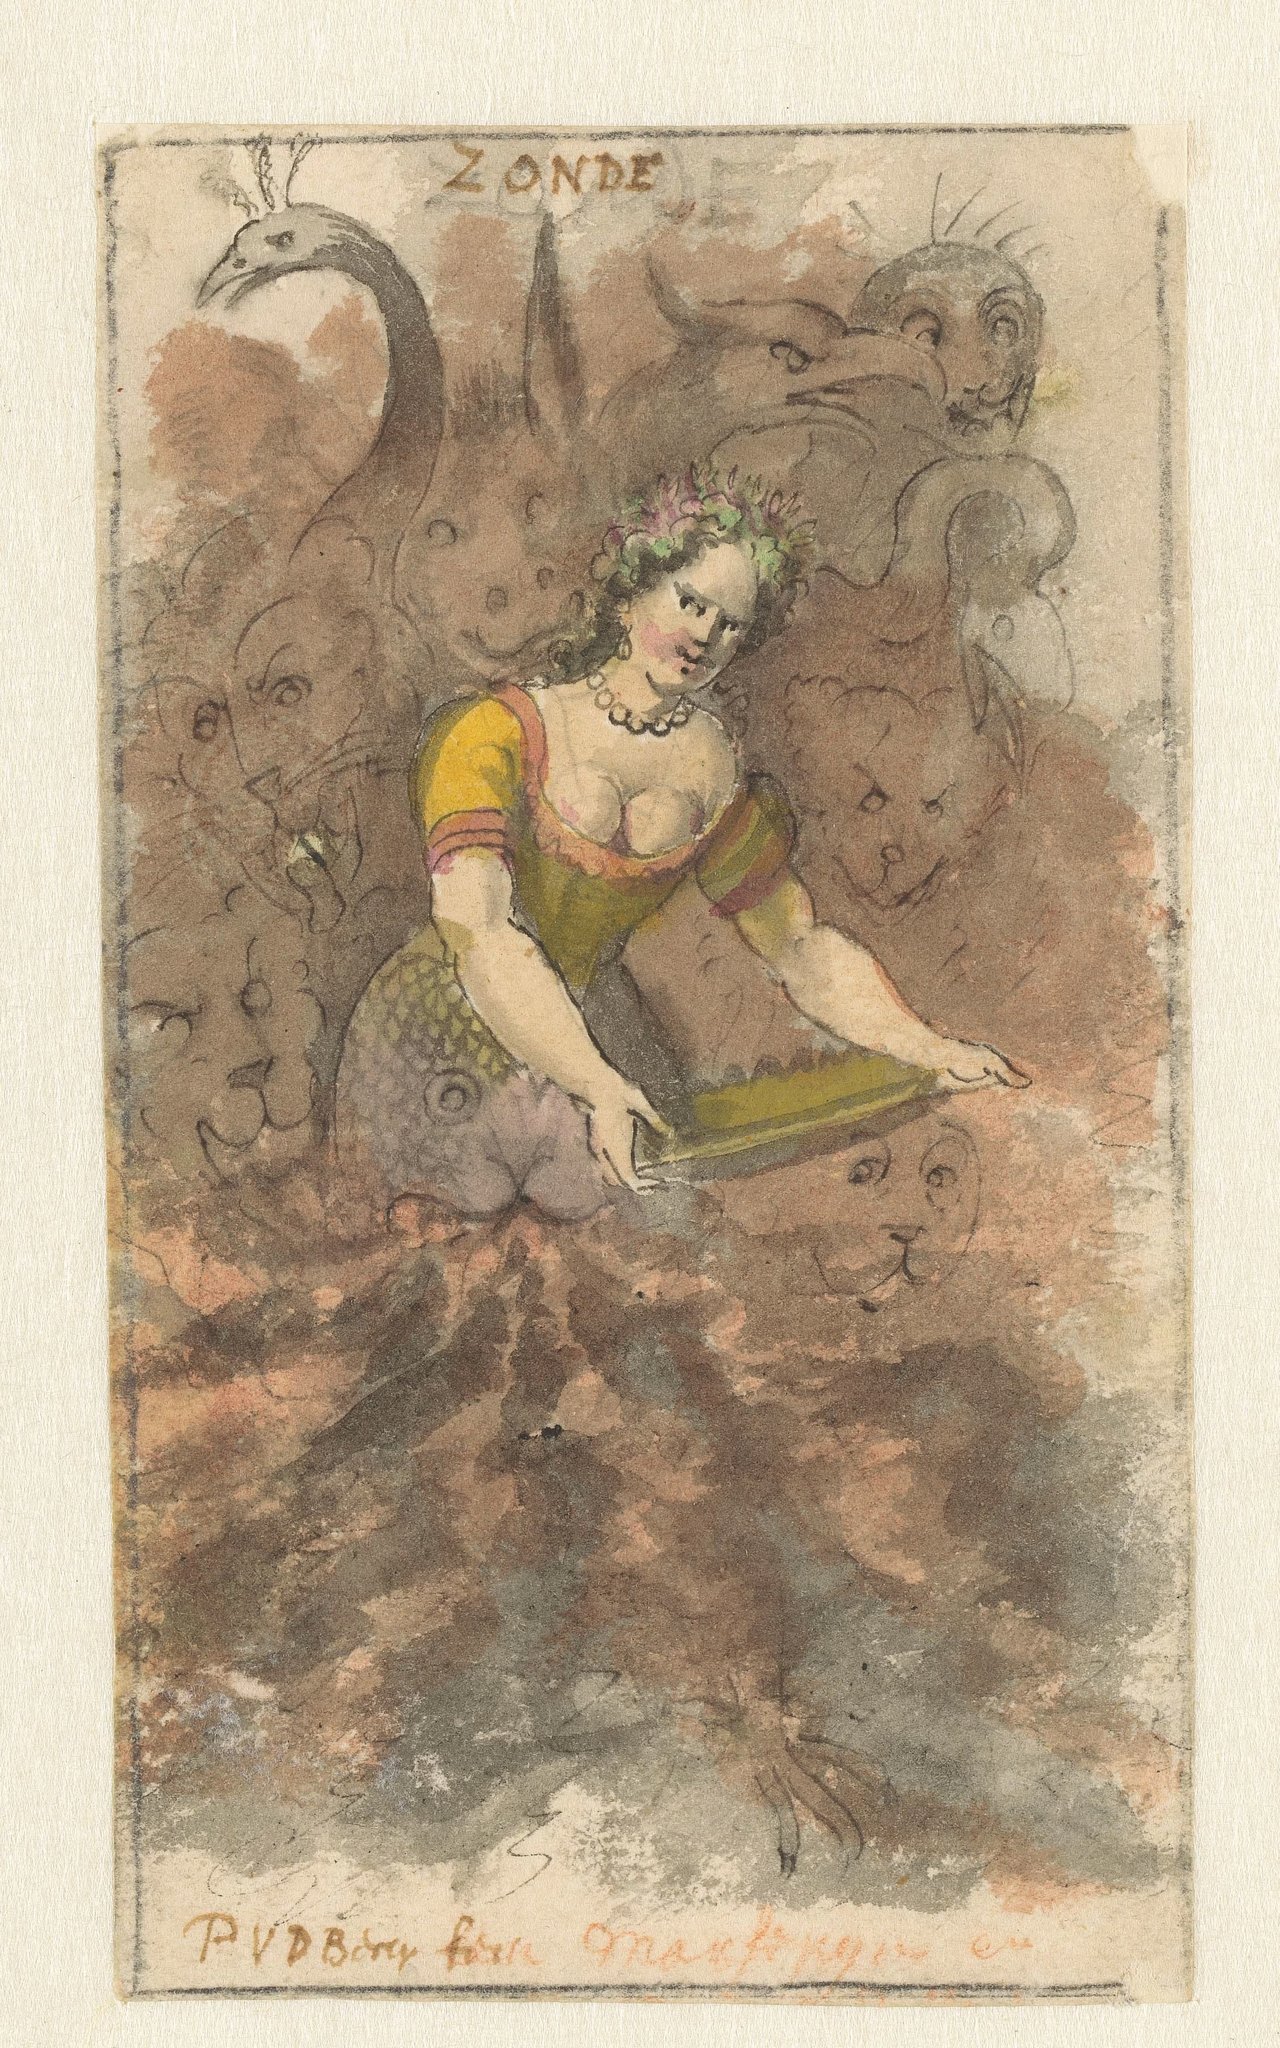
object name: drawing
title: Zonde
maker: pieter van den berge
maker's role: draughtsman, print maker, printer, publisher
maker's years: 1659-1737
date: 1675-1737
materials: chalk, ink, paper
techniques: brush, pen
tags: vice, evil, sin; 'peccato' (ripa)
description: Een vrouw houdt een schaal met beide handen voor zich. Zij bevindt zich temidden van nevels, met daarin allerlei koppen van dieren.